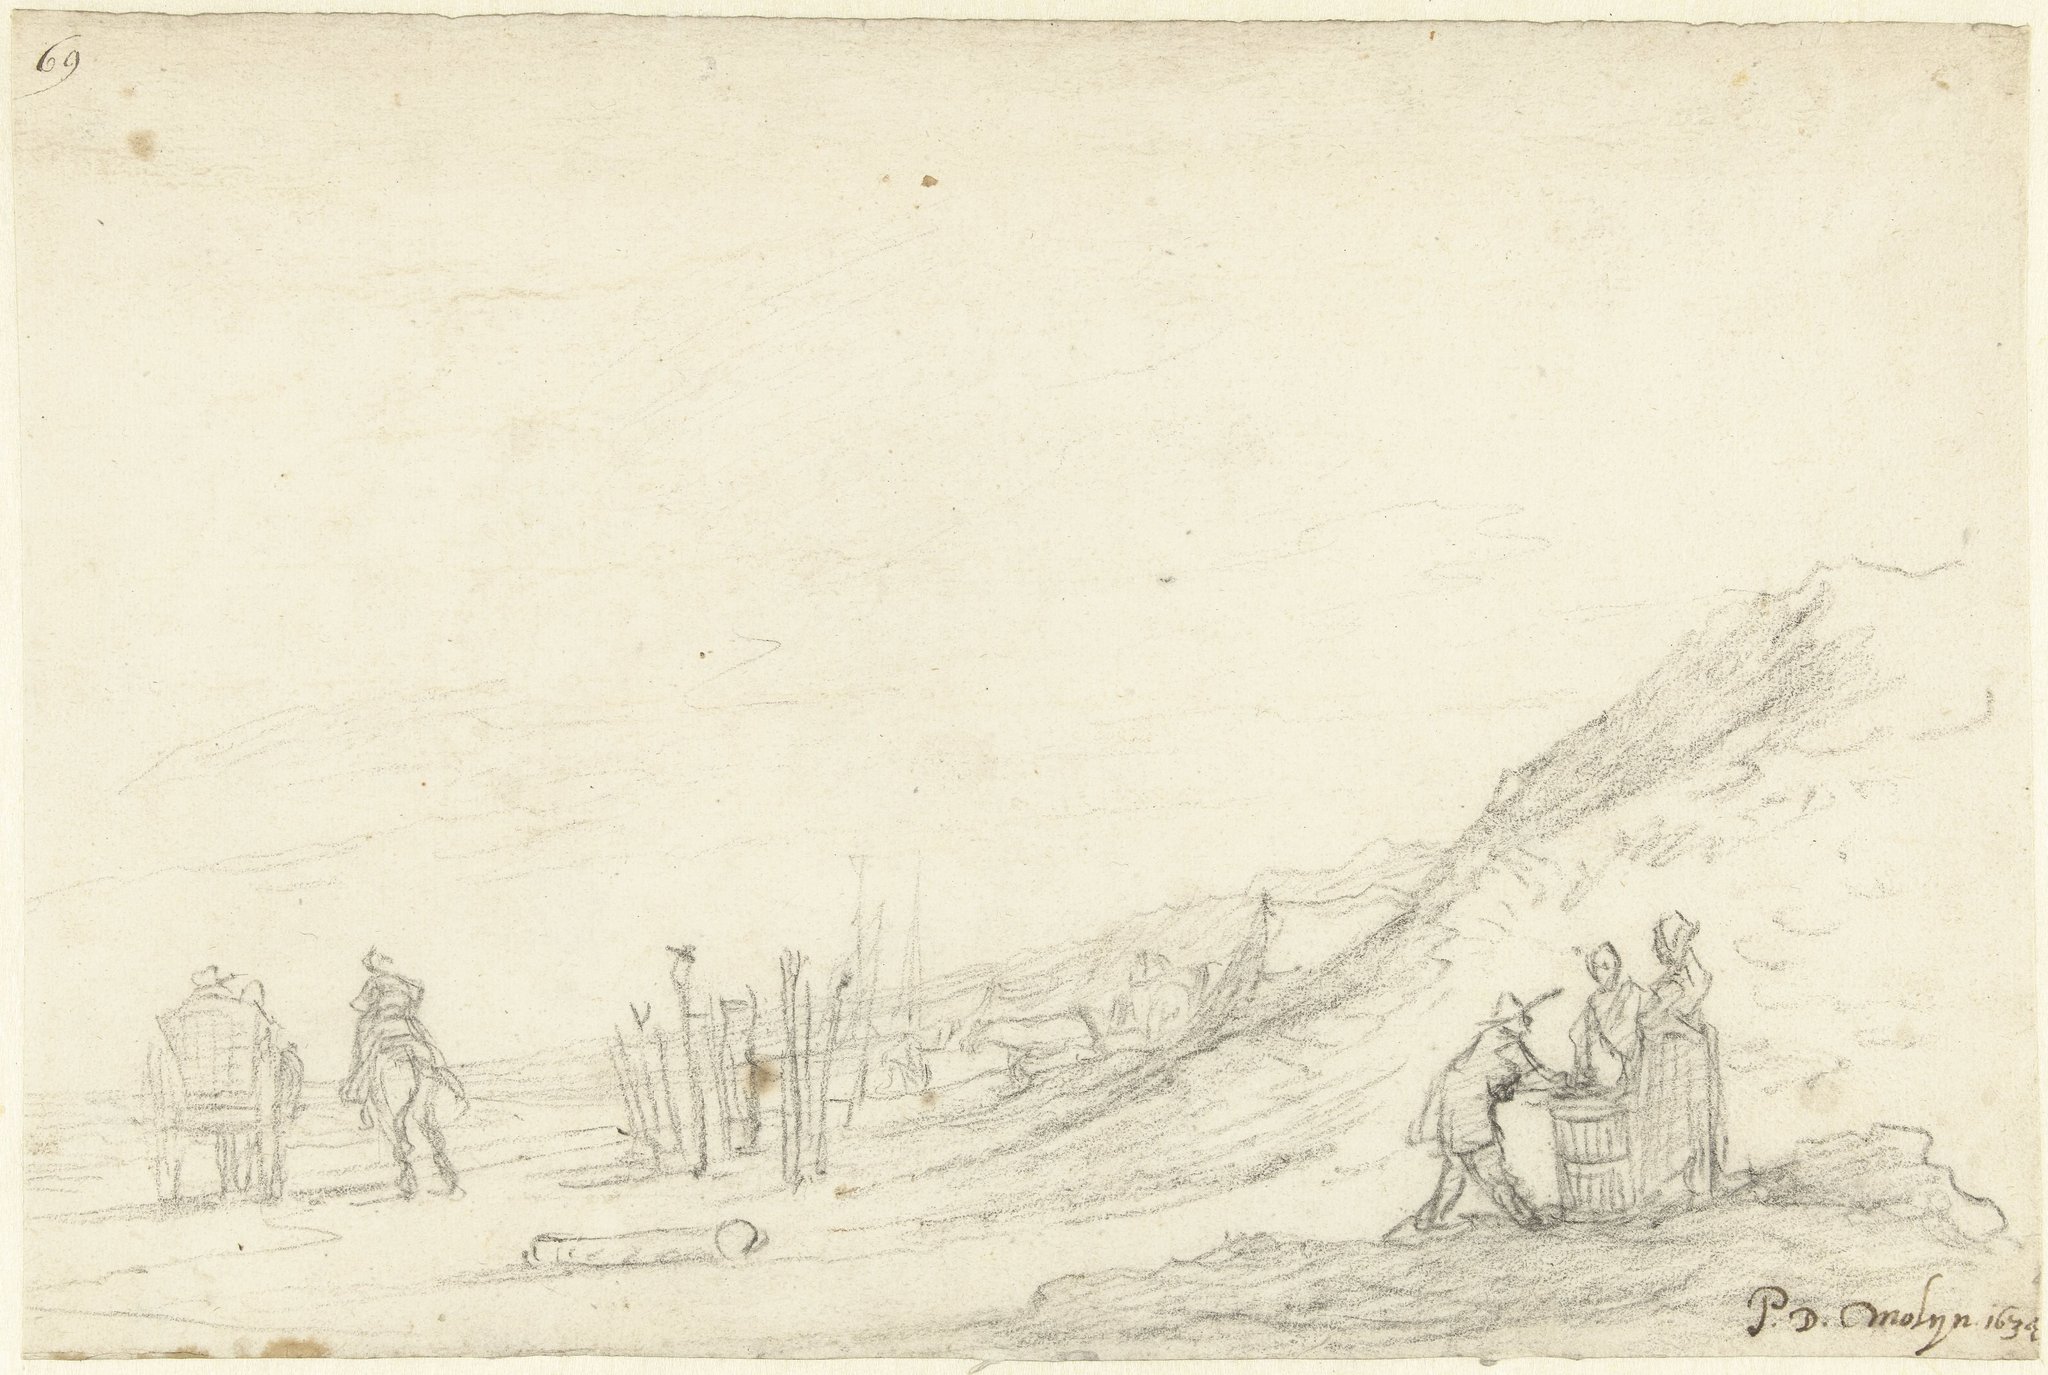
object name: drawing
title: Strandgezicht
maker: gerard ter borch (ii)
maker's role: draughtsman, painter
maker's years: 1617-1681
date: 1634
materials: chalk, paper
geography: haarlem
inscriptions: date and inscription: ‘P.D.Molyn 1634’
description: Deel van een groep tekeningen (GJr 43-51) gemaakt in het atelier van Molijn. Aanvankelijk toegeschreven aan Pieter Molijn, vanwege de annotatie, maar waarschijnlijk door Gerard (II) gemaakt onder leiding van zijn leermeester Molijn in diens atelier.